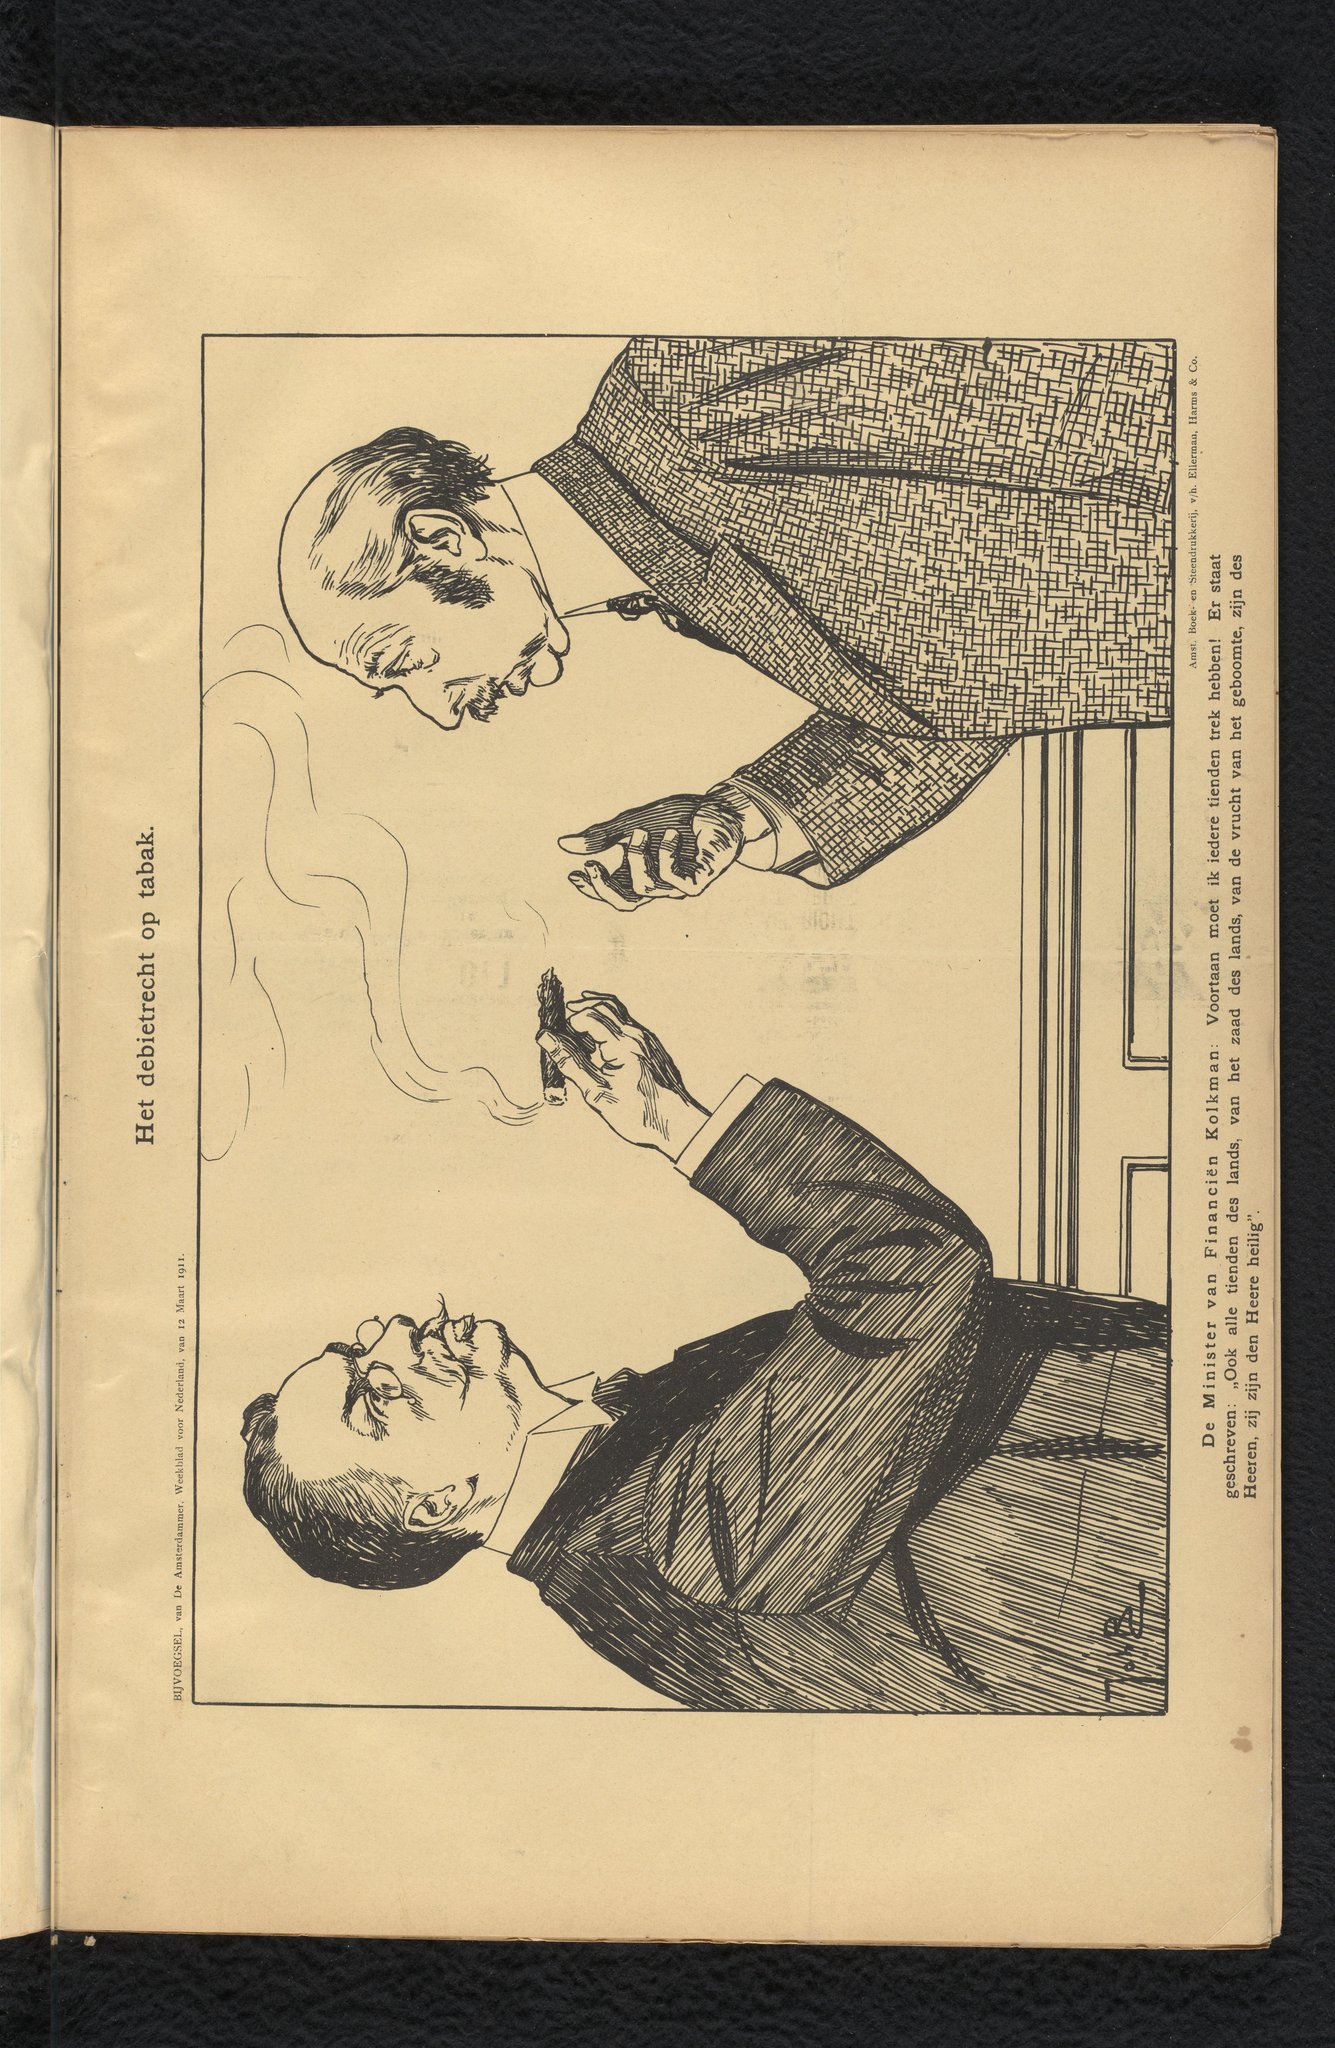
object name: cartoon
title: Het debietrecht op tabak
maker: johan braakensiek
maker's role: draughtsman, print maker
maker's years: 1858-1940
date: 1911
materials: paper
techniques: lithograph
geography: amsterdam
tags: dordrecht, the hague, politician, cigar, tax collection, political caricatures and satires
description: Minister van Financiën Kolkman eist de tiende trek van een sigaar op, tot verbijstering van de roker. Naar aanleiding van accijnzen op tabak.